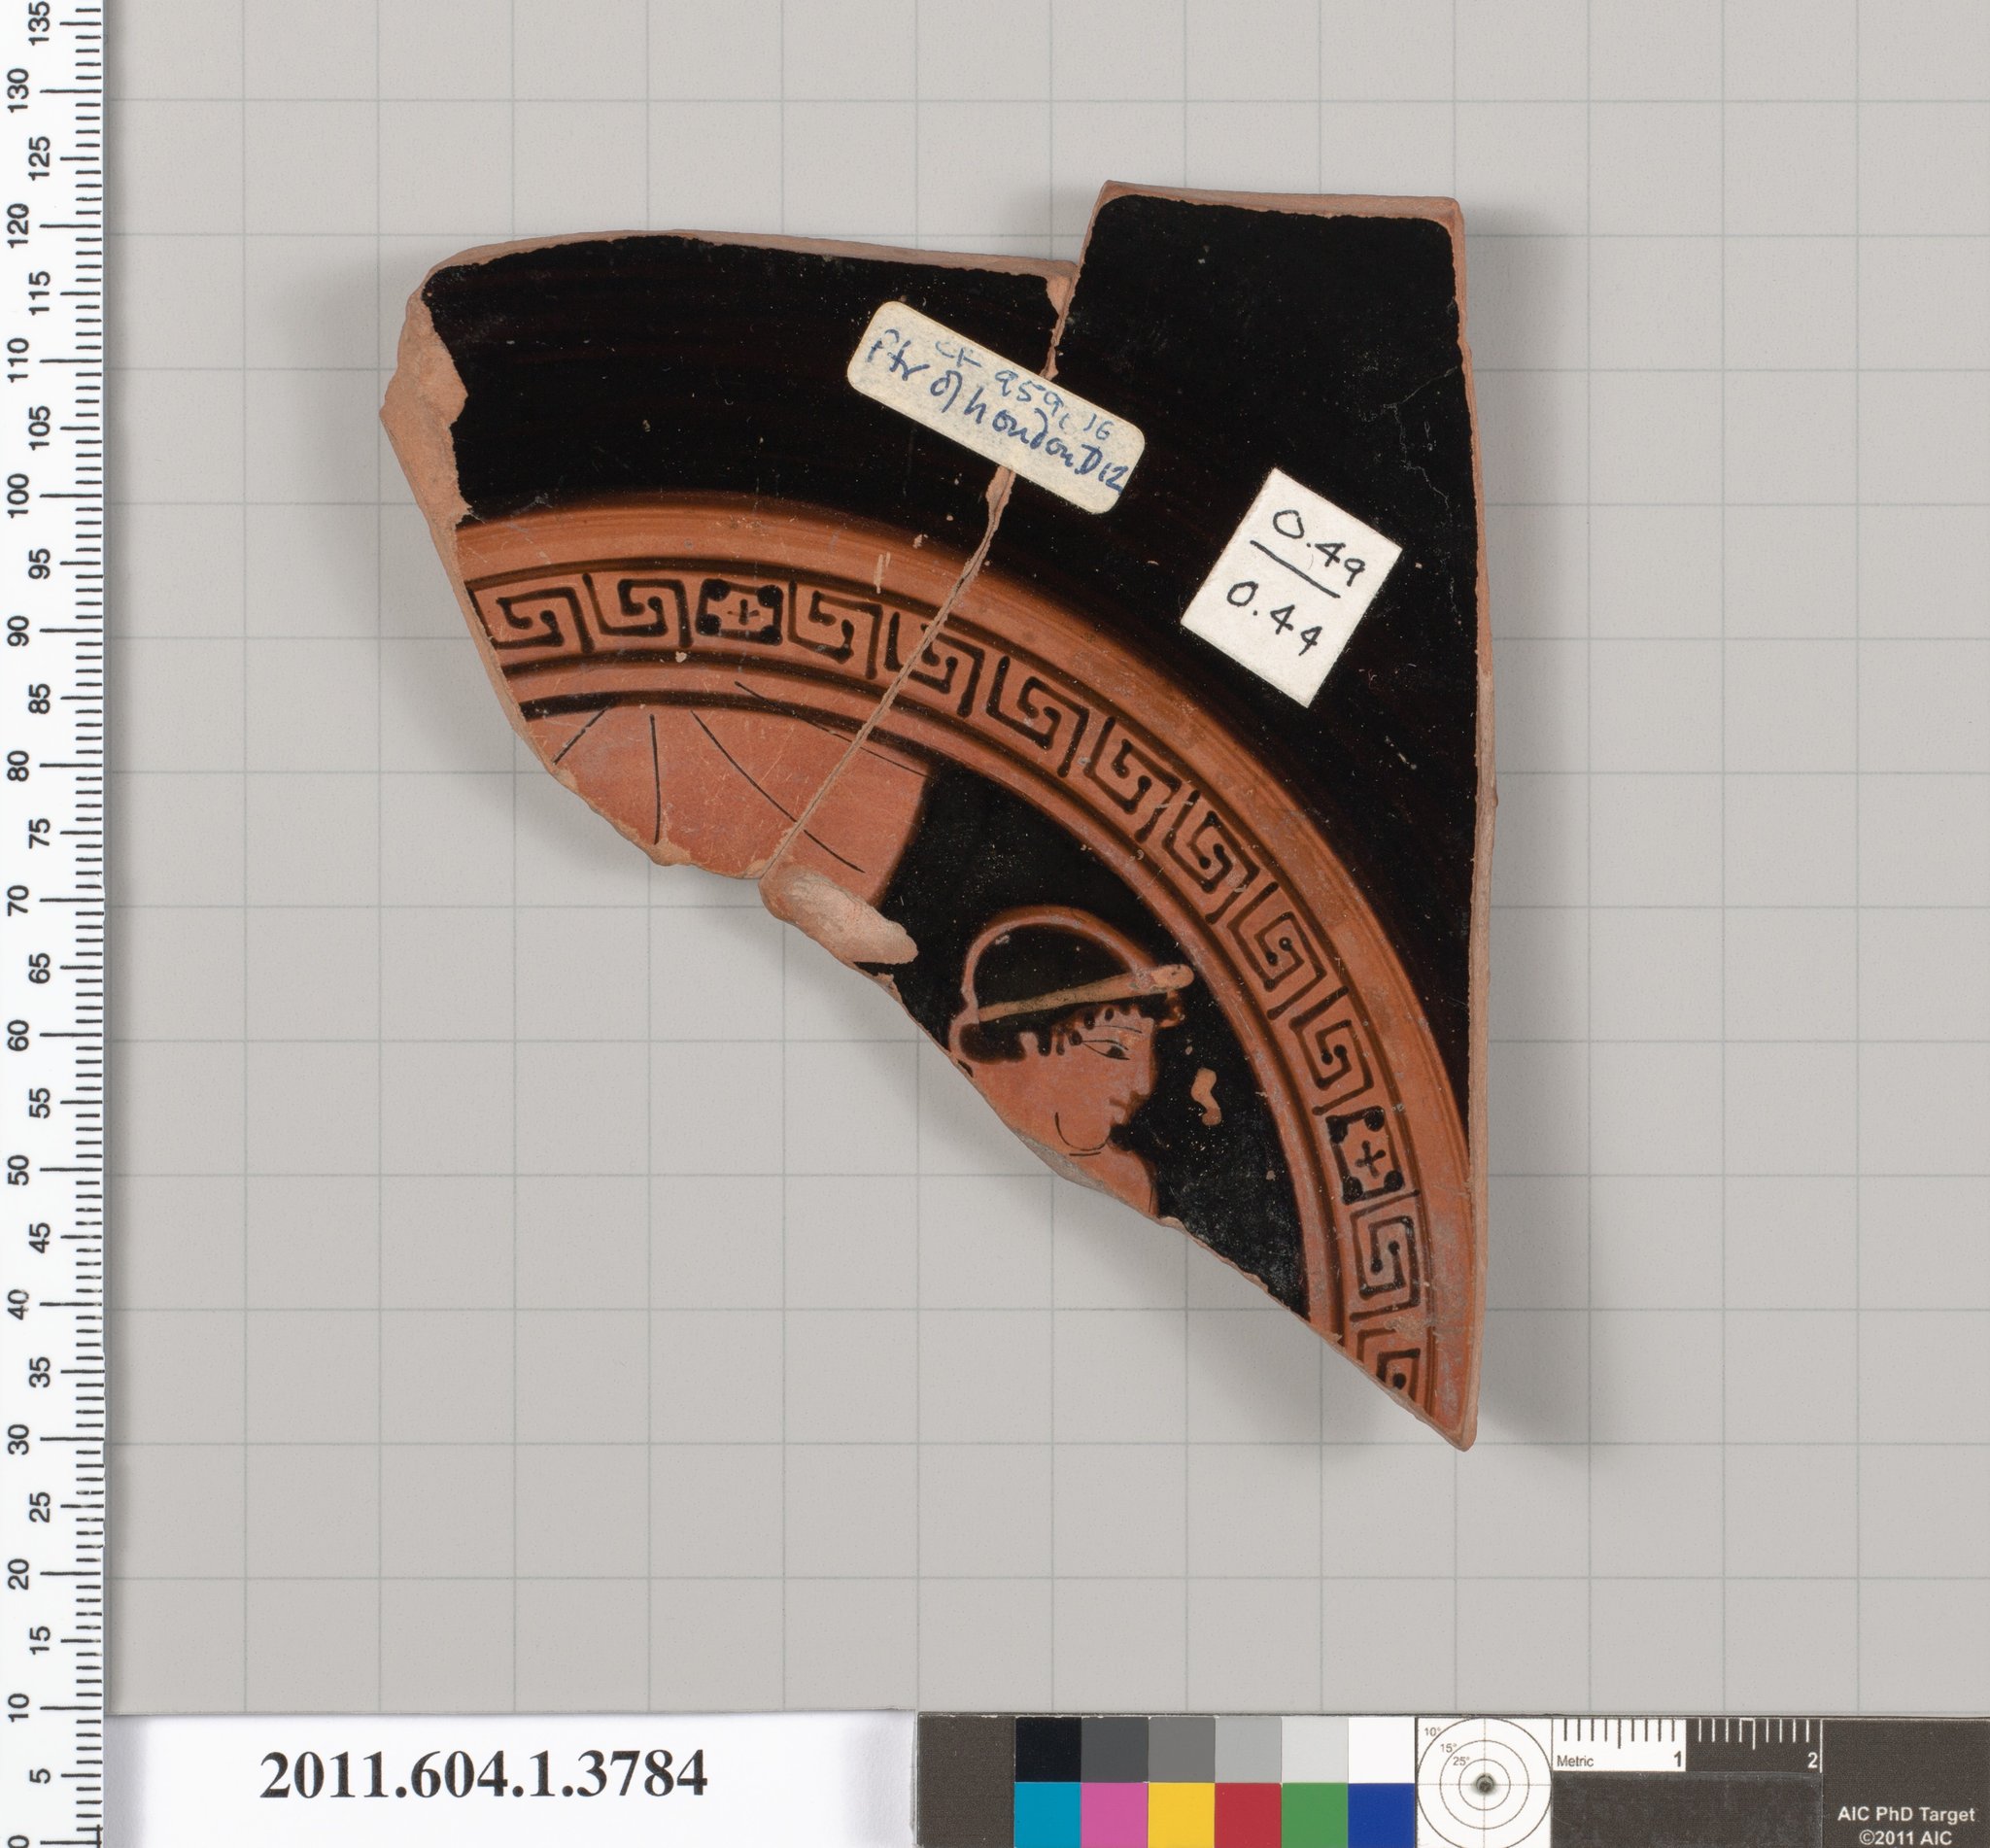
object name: kylix fragment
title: Terracotta fragment of a kylix (drinking cup)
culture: greek, attic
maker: painter of london d 12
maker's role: artist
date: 475-451 BCE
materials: terracotta